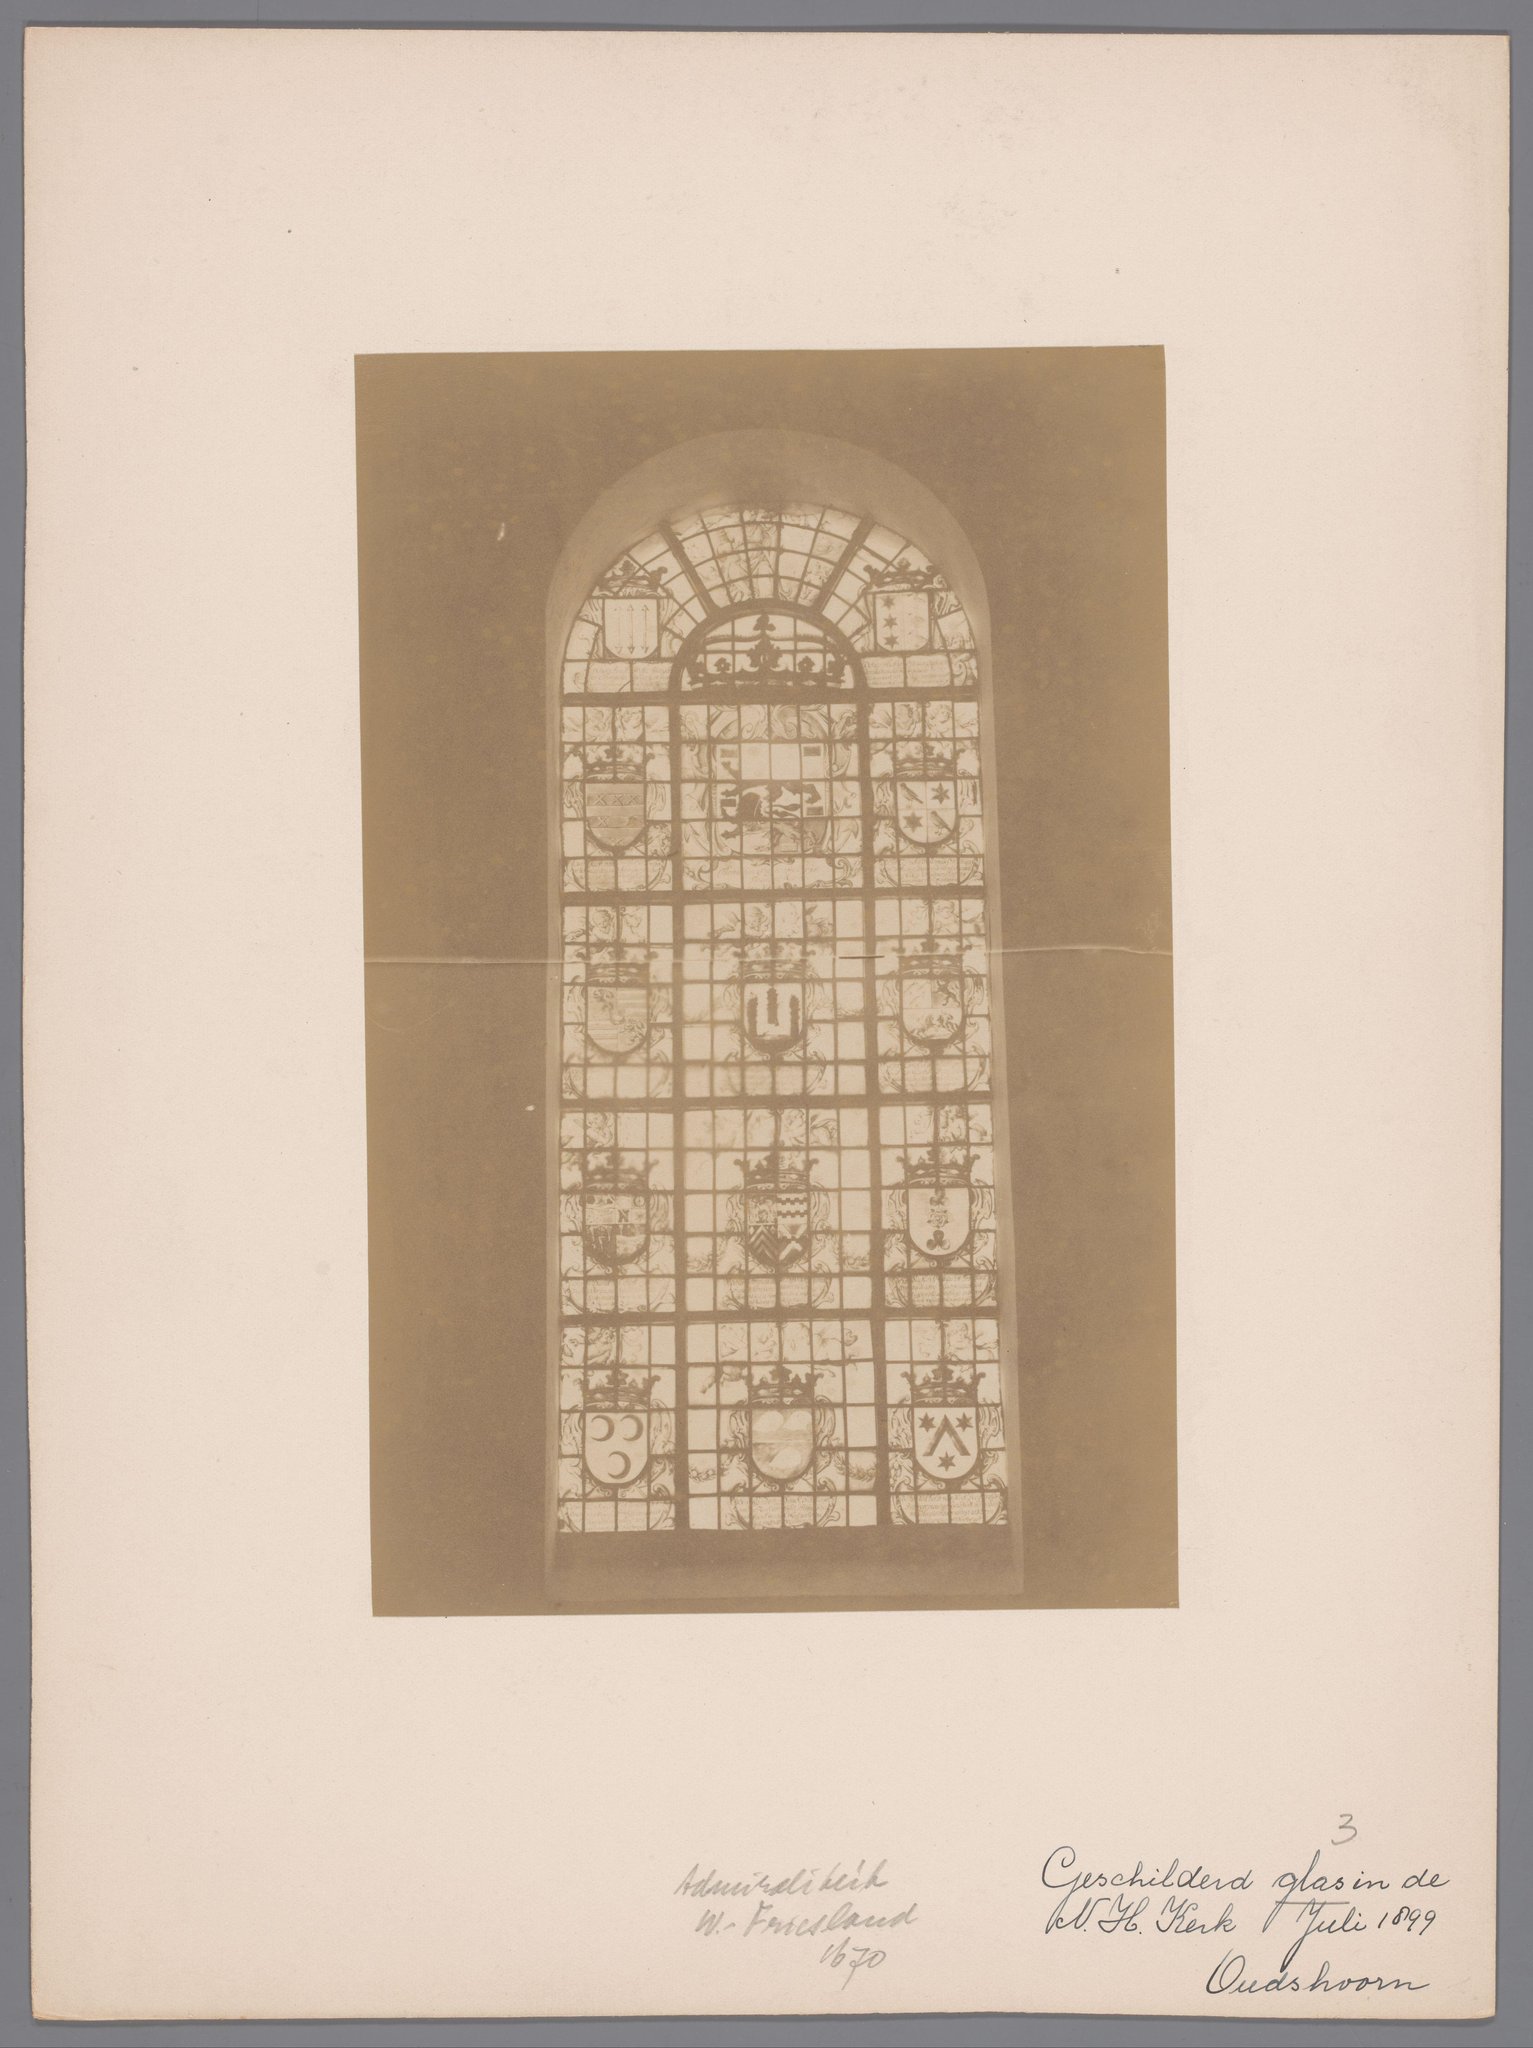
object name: photograph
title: Geschilderd raam in de Oudshoornse Kerk te Oudshoorn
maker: anoniem (monumentenzorg)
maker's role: fotograaf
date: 1899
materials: cardboard, photographic support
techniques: albumen print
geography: oudshoorn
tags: church-window, e.g. rose-window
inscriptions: annotation: ‘Geschilderd glas in de Ned Herv kerk te Oudshoorn (Z.H.)/ Juli 1899’, annotation: ‘Geschilderd glas 3 in de N.H. Kerk Juli 1899/ Oudshoorn’, annotation: ‘Admiraliteit W. Friesland 1670’